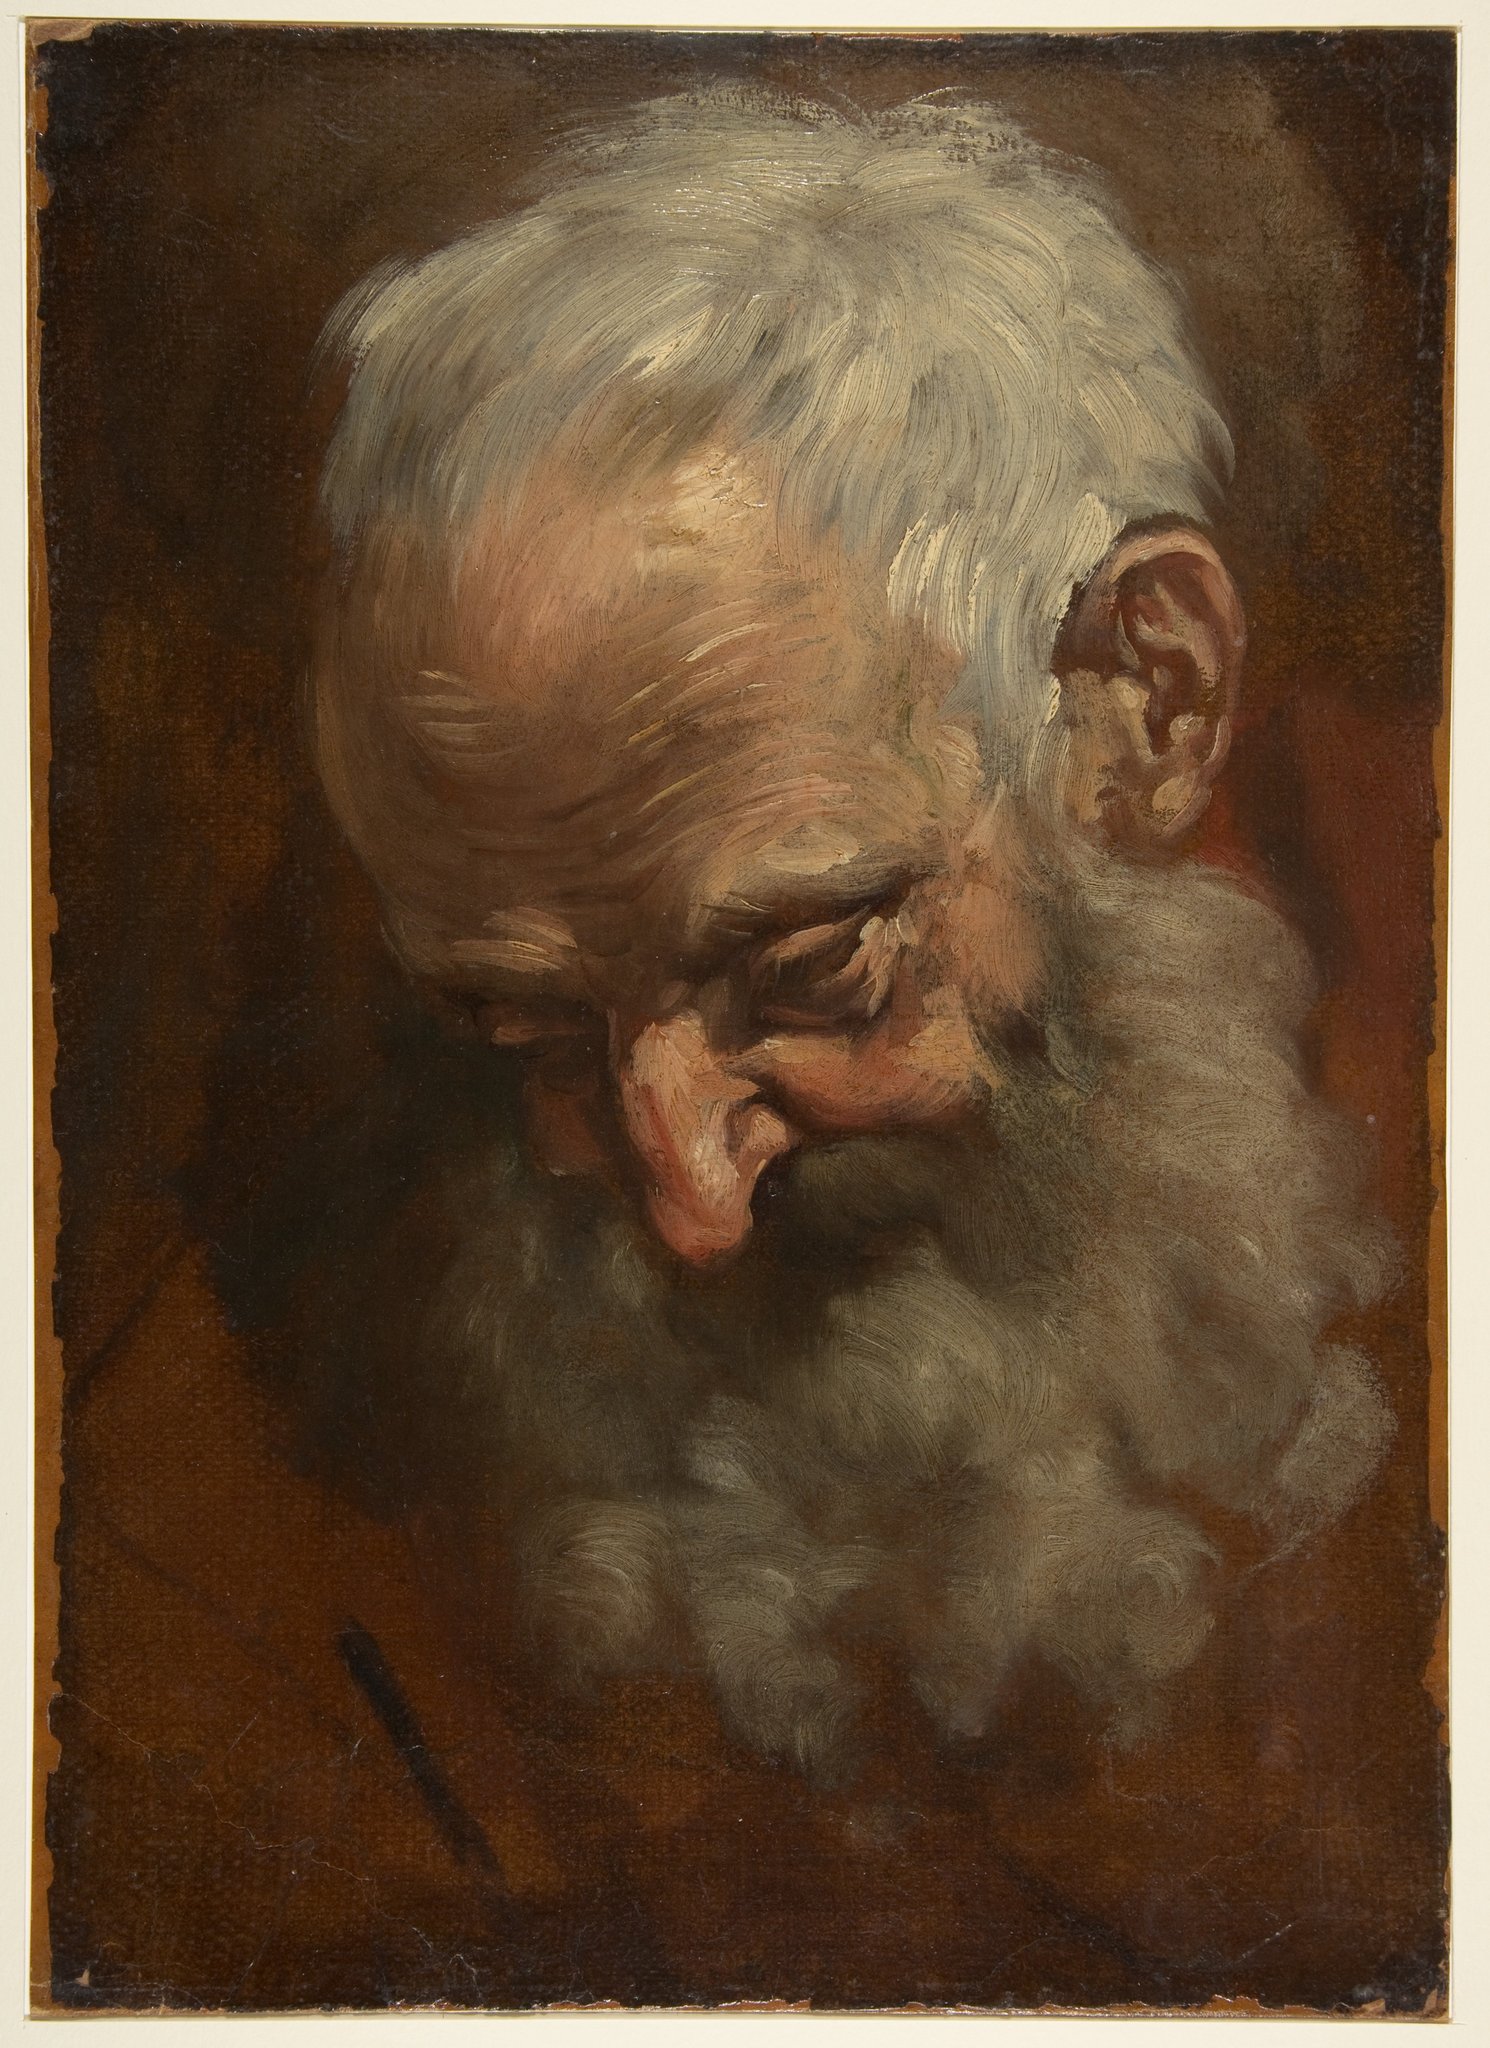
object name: drawing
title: Head of a Bearded Man (Nicodemus)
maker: giacomo cavedone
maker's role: artist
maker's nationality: italian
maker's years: 1577-1660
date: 1577-1660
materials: oil, paper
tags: heads,men